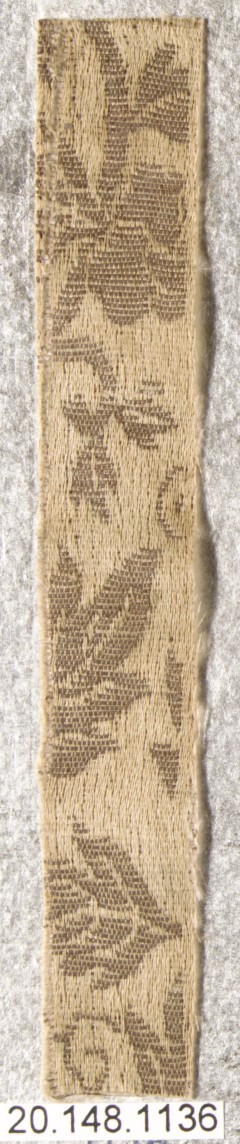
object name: piece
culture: japanese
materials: silk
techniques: compound weave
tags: leaves